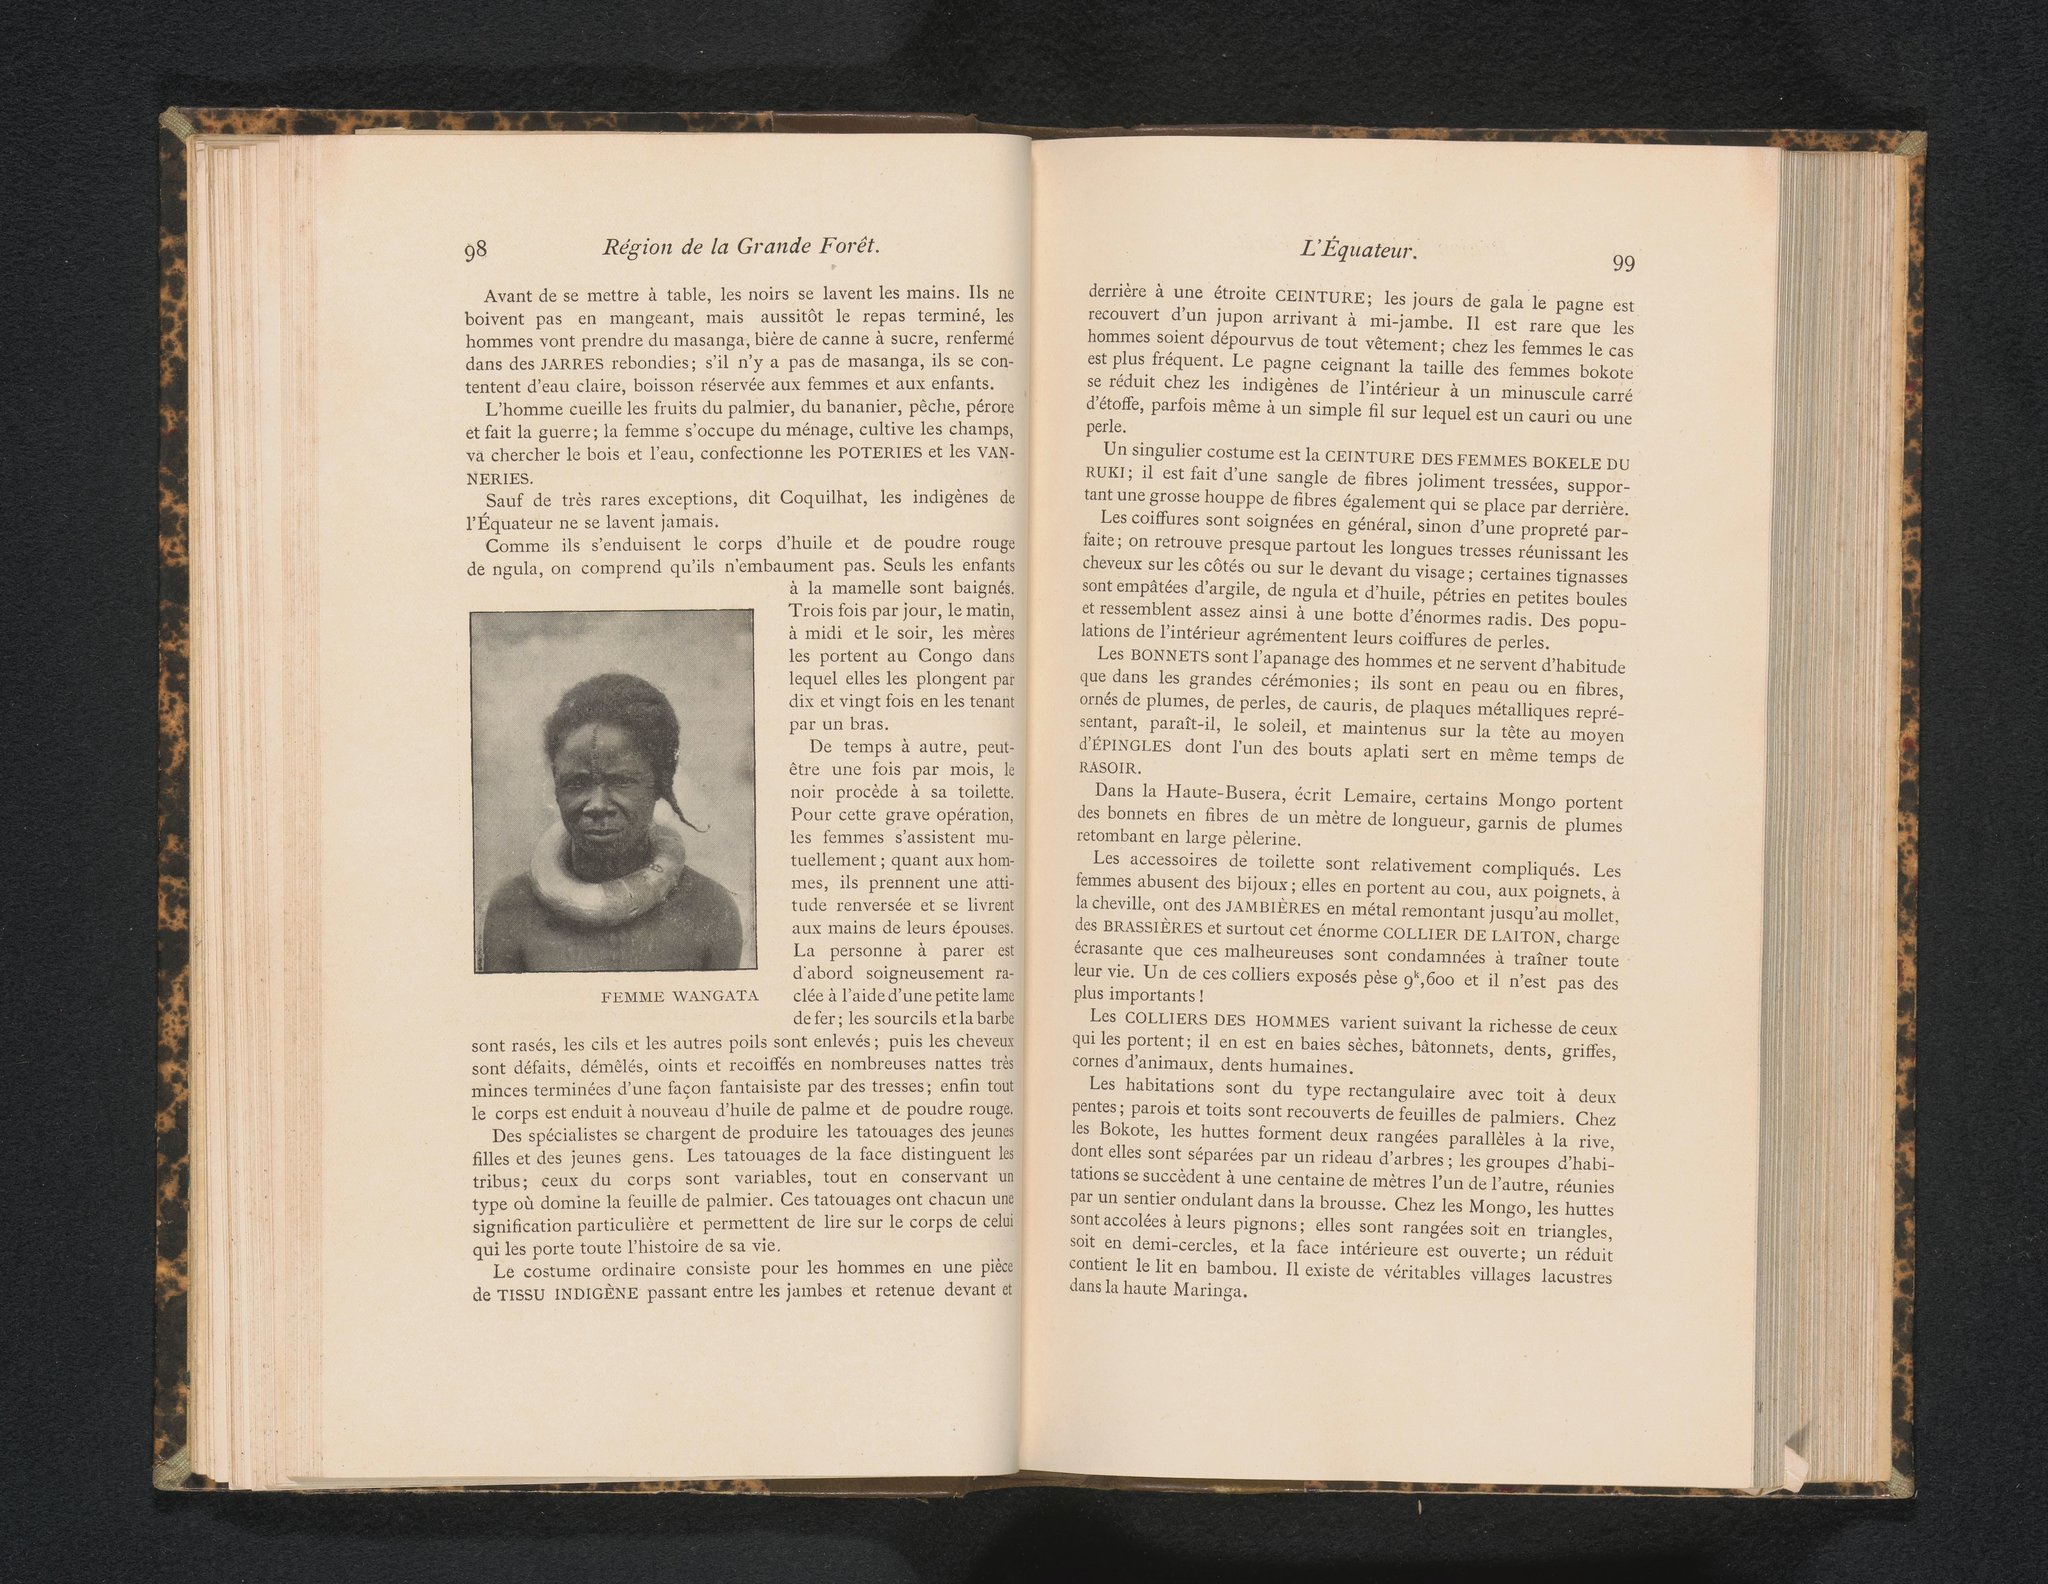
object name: photomechanical print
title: Portret van een onbekende vrouw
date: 1892-1897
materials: paper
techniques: autotype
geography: congo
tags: historical persons - bb - woman